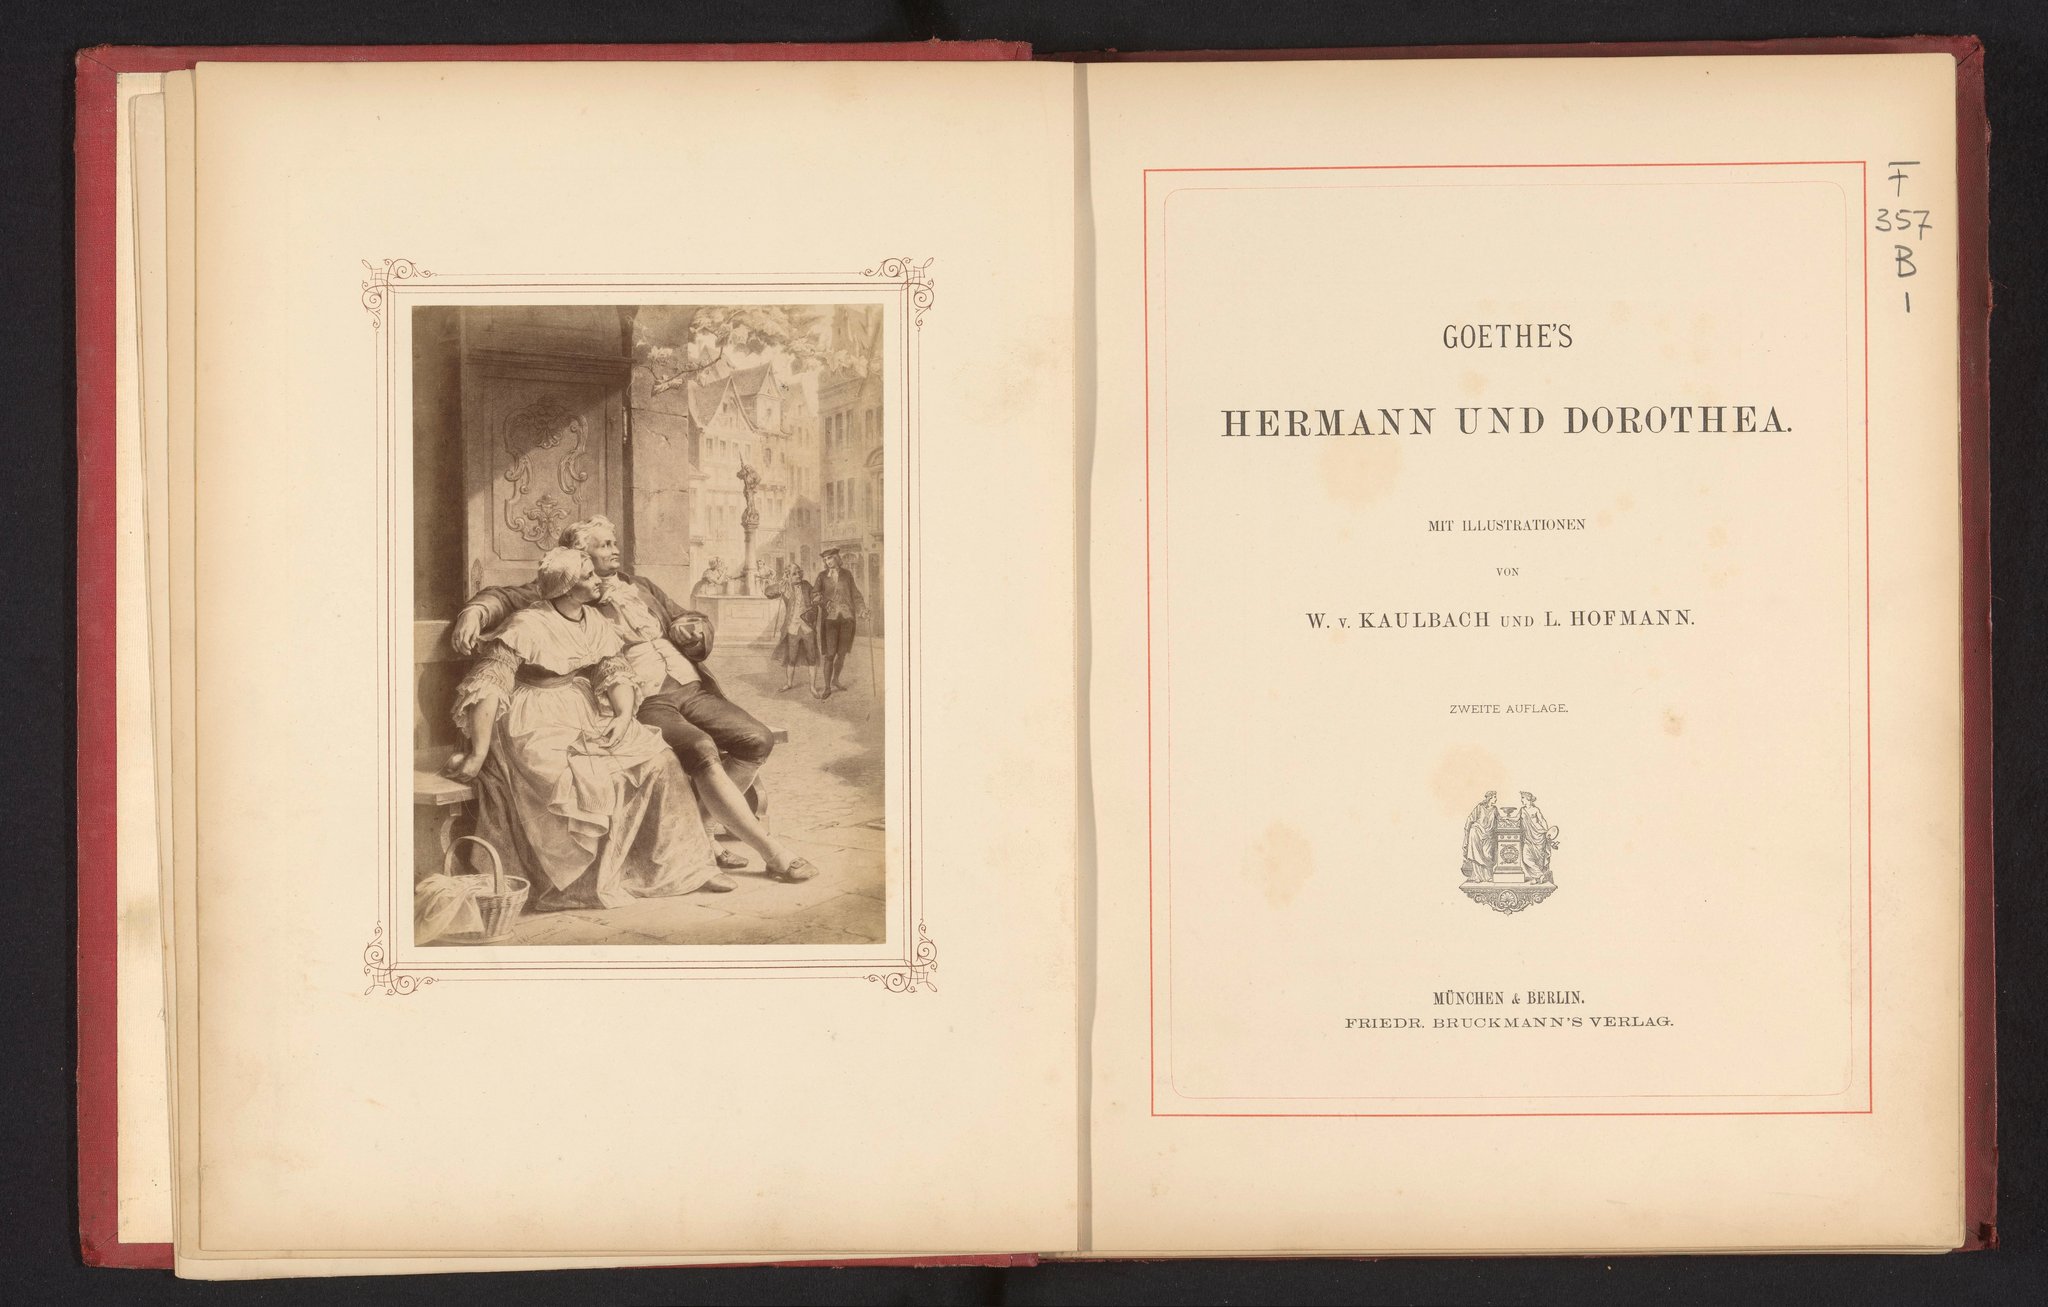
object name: page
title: Fotoreproductie van een schilderij, voorstellende de ouders van Hermann op een bank naast een plein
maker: franz seraph hanfstaengl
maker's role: painter, print maker, printer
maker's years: 1804-1877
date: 1867-1872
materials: photographic support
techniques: albumen print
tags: bench, marriage, married couple, 'matrimonium'